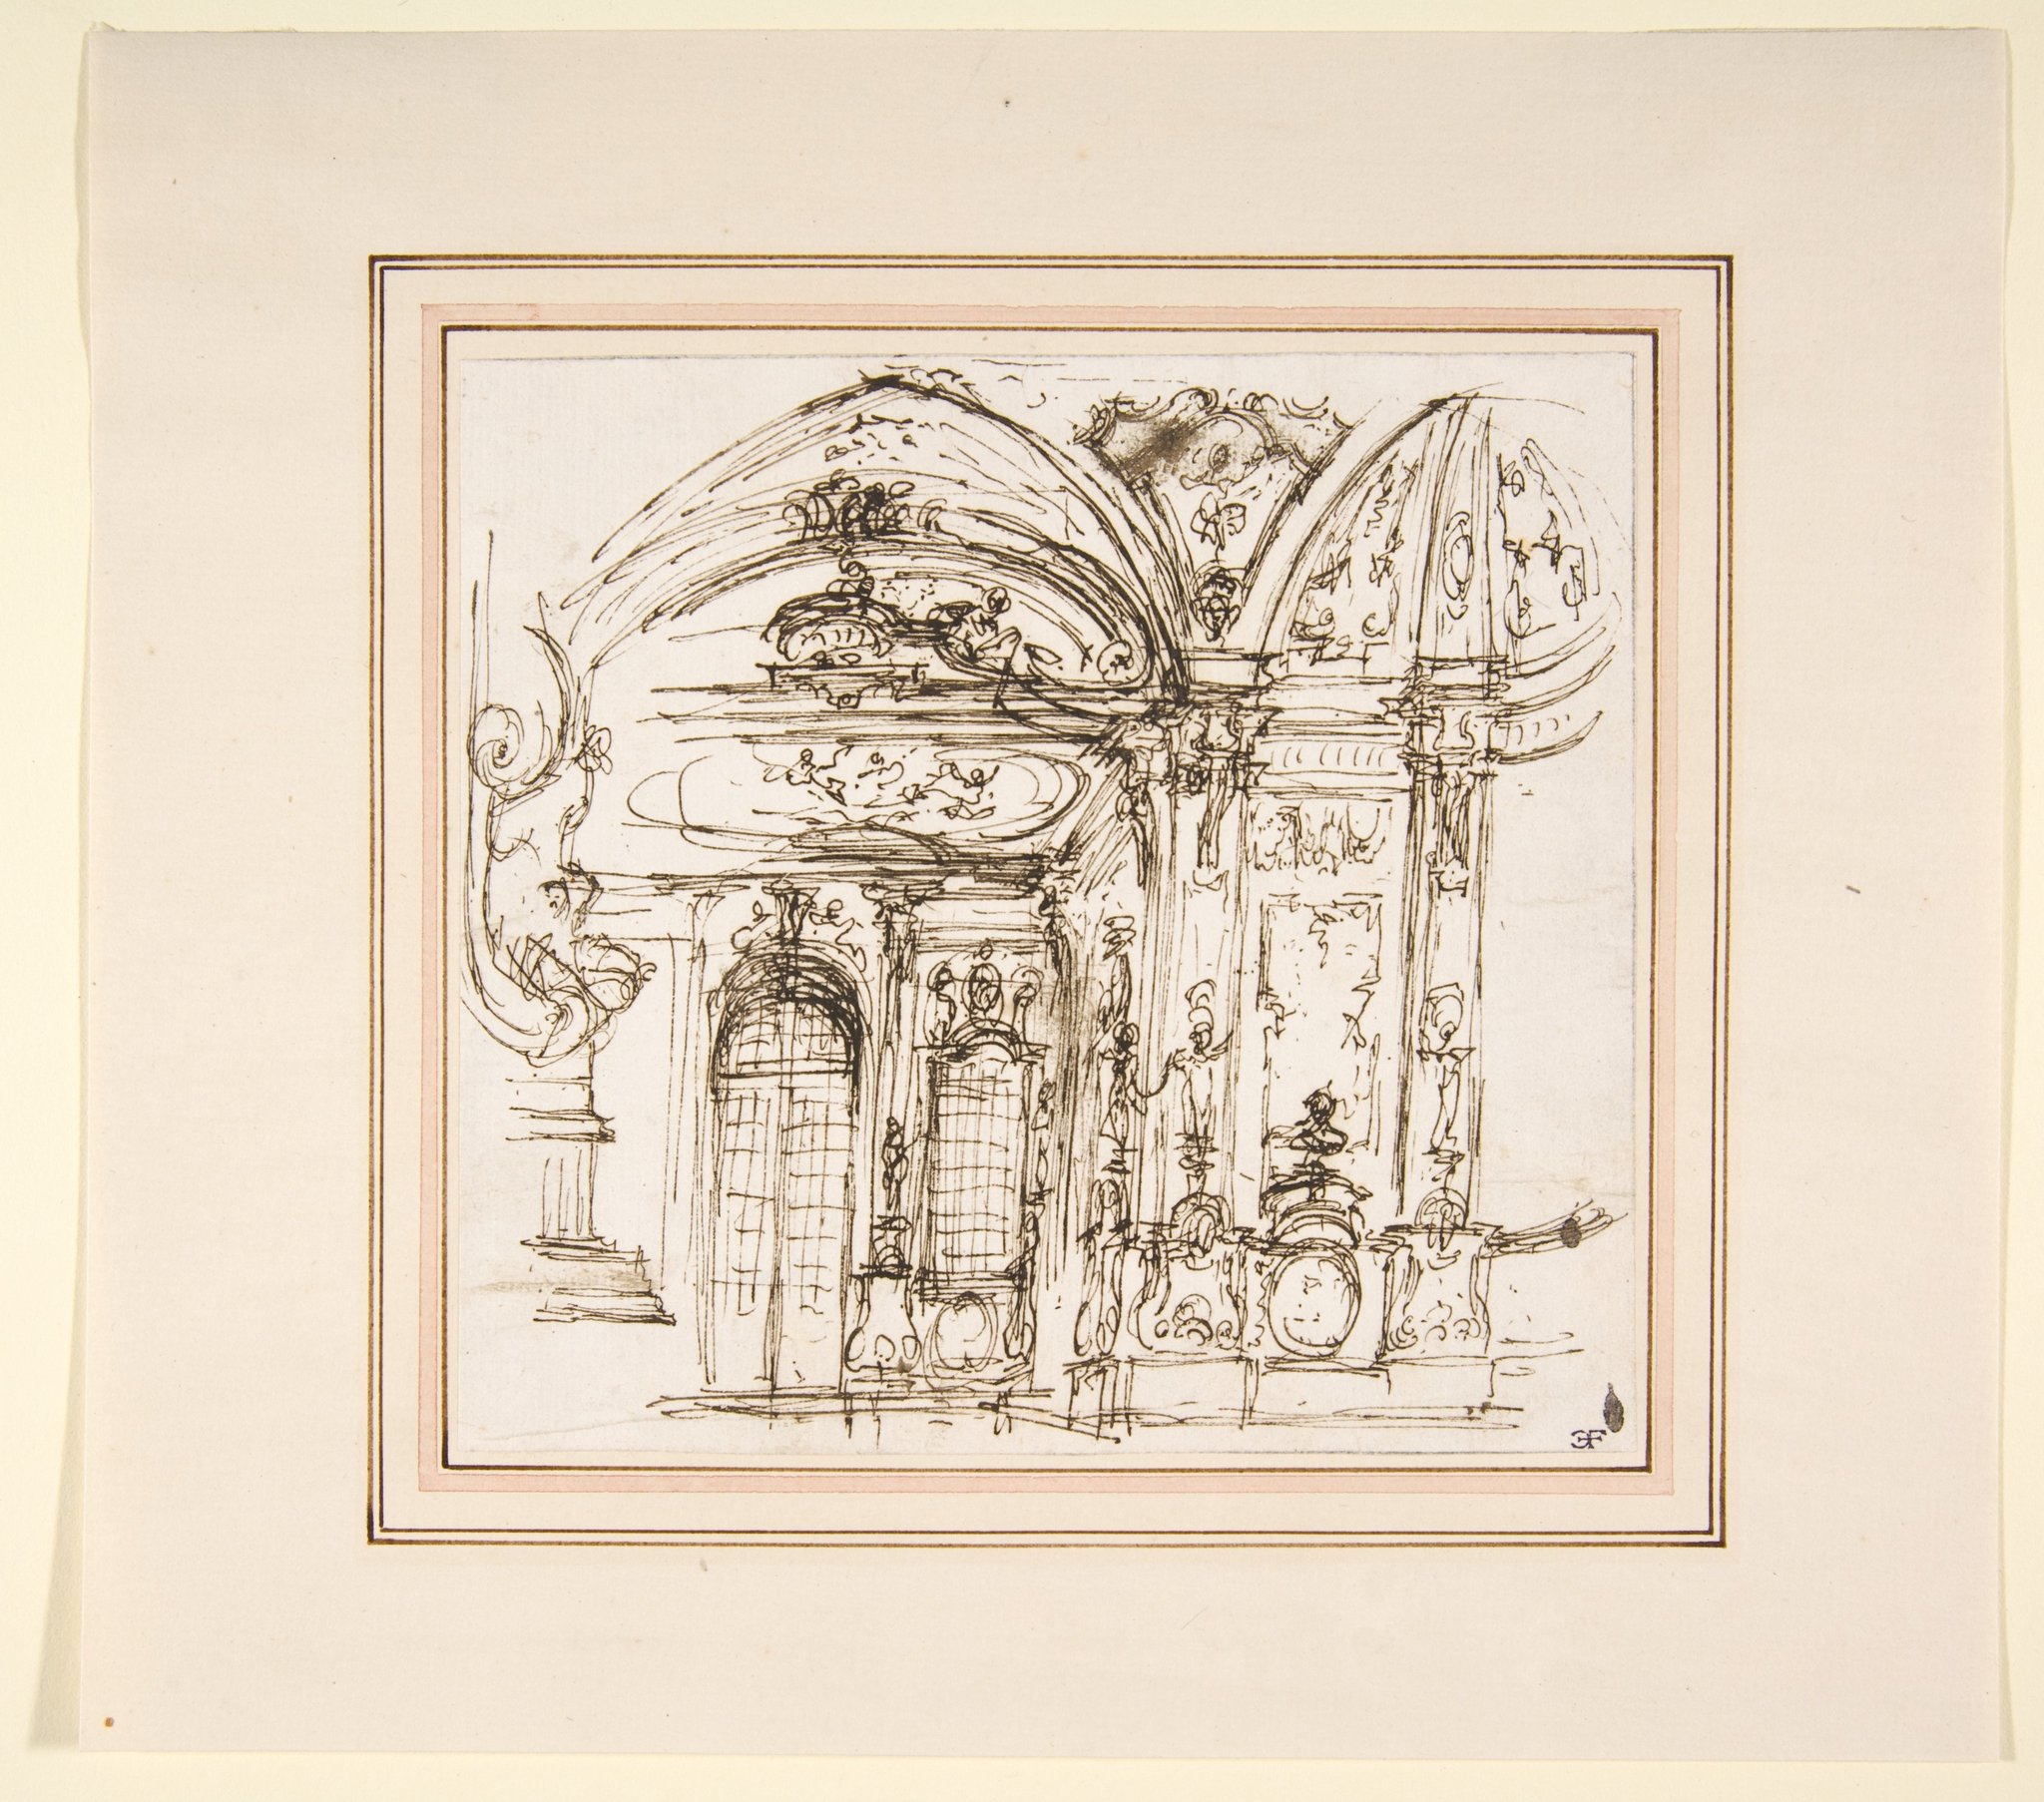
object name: drawing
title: Design for a Stage Set: Highly Decorated Interior of a Palace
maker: giuseppe valeriani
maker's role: artist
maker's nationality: italian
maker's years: 1708-1761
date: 1740-1770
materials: ink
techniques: pen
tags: interiors,stage design